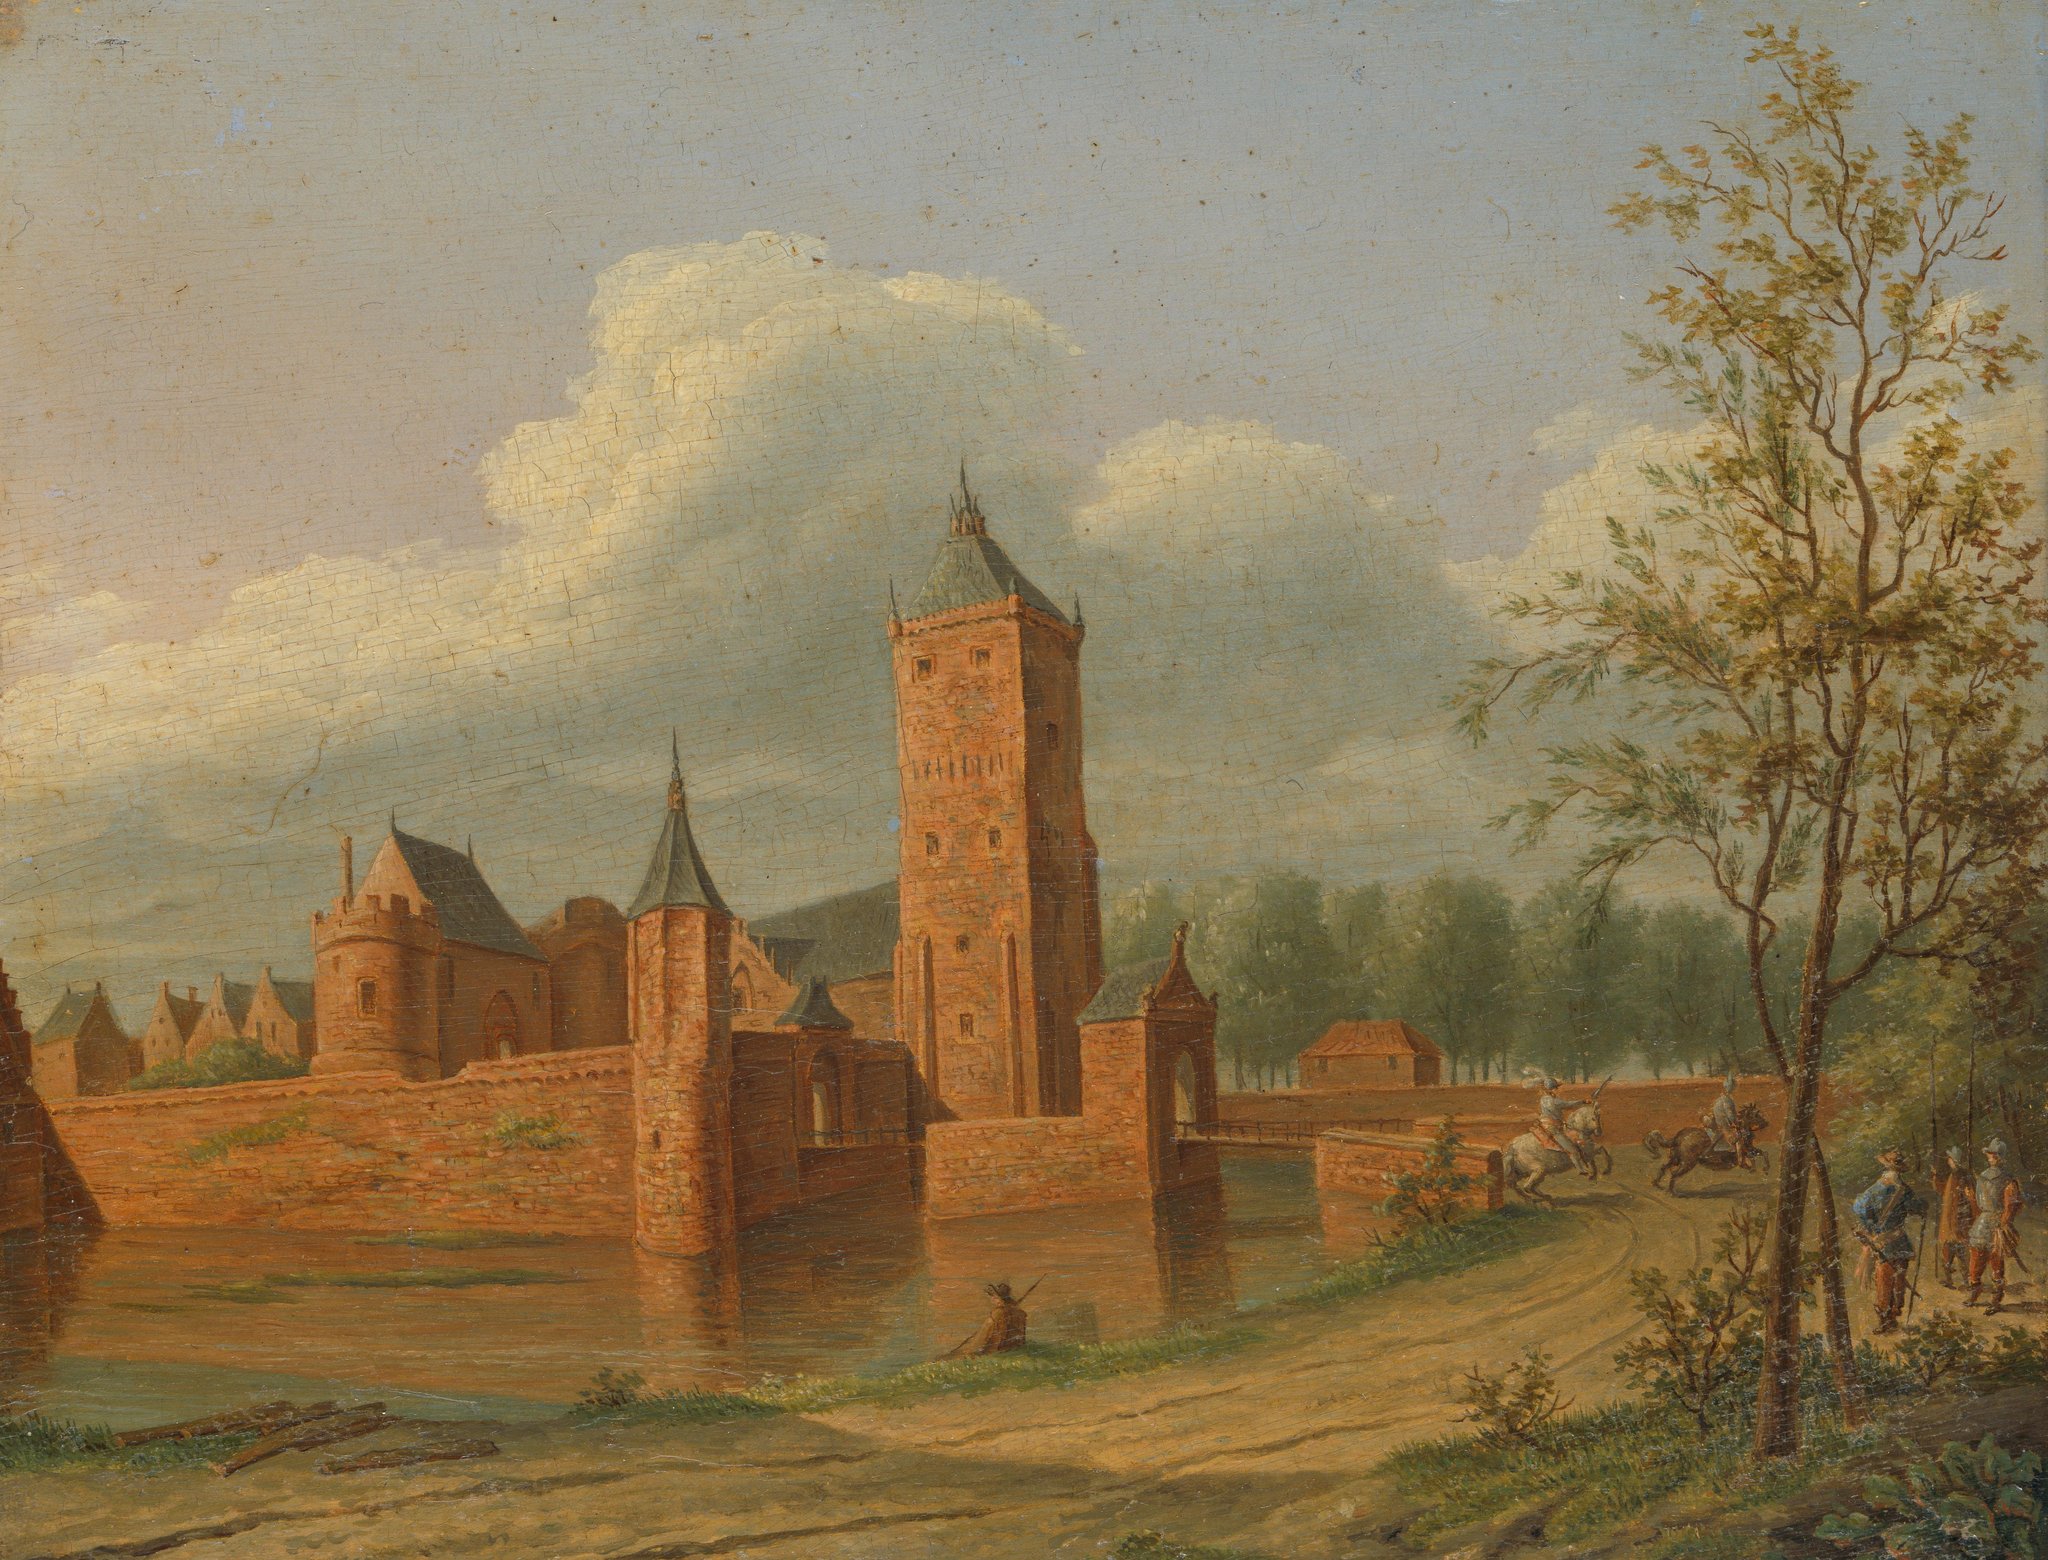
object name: painting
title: Batestein Castle near Vianen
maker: jan jacob teyler van hall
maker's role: painter, print maker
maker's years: 1794-1851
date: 1840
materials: oil, panel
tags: castle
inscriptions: signature and date: ‘J.J. Teyler van Hall 1840’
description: Gezicht op het Slot Batestein bij Vianen, met de vierkante toren genaamd St. Paul. Om het kasteel een slotgracht. Bij de slotbrug bevinden zich twee ruiters. Rechts langs de weg staan enkele soldaten.